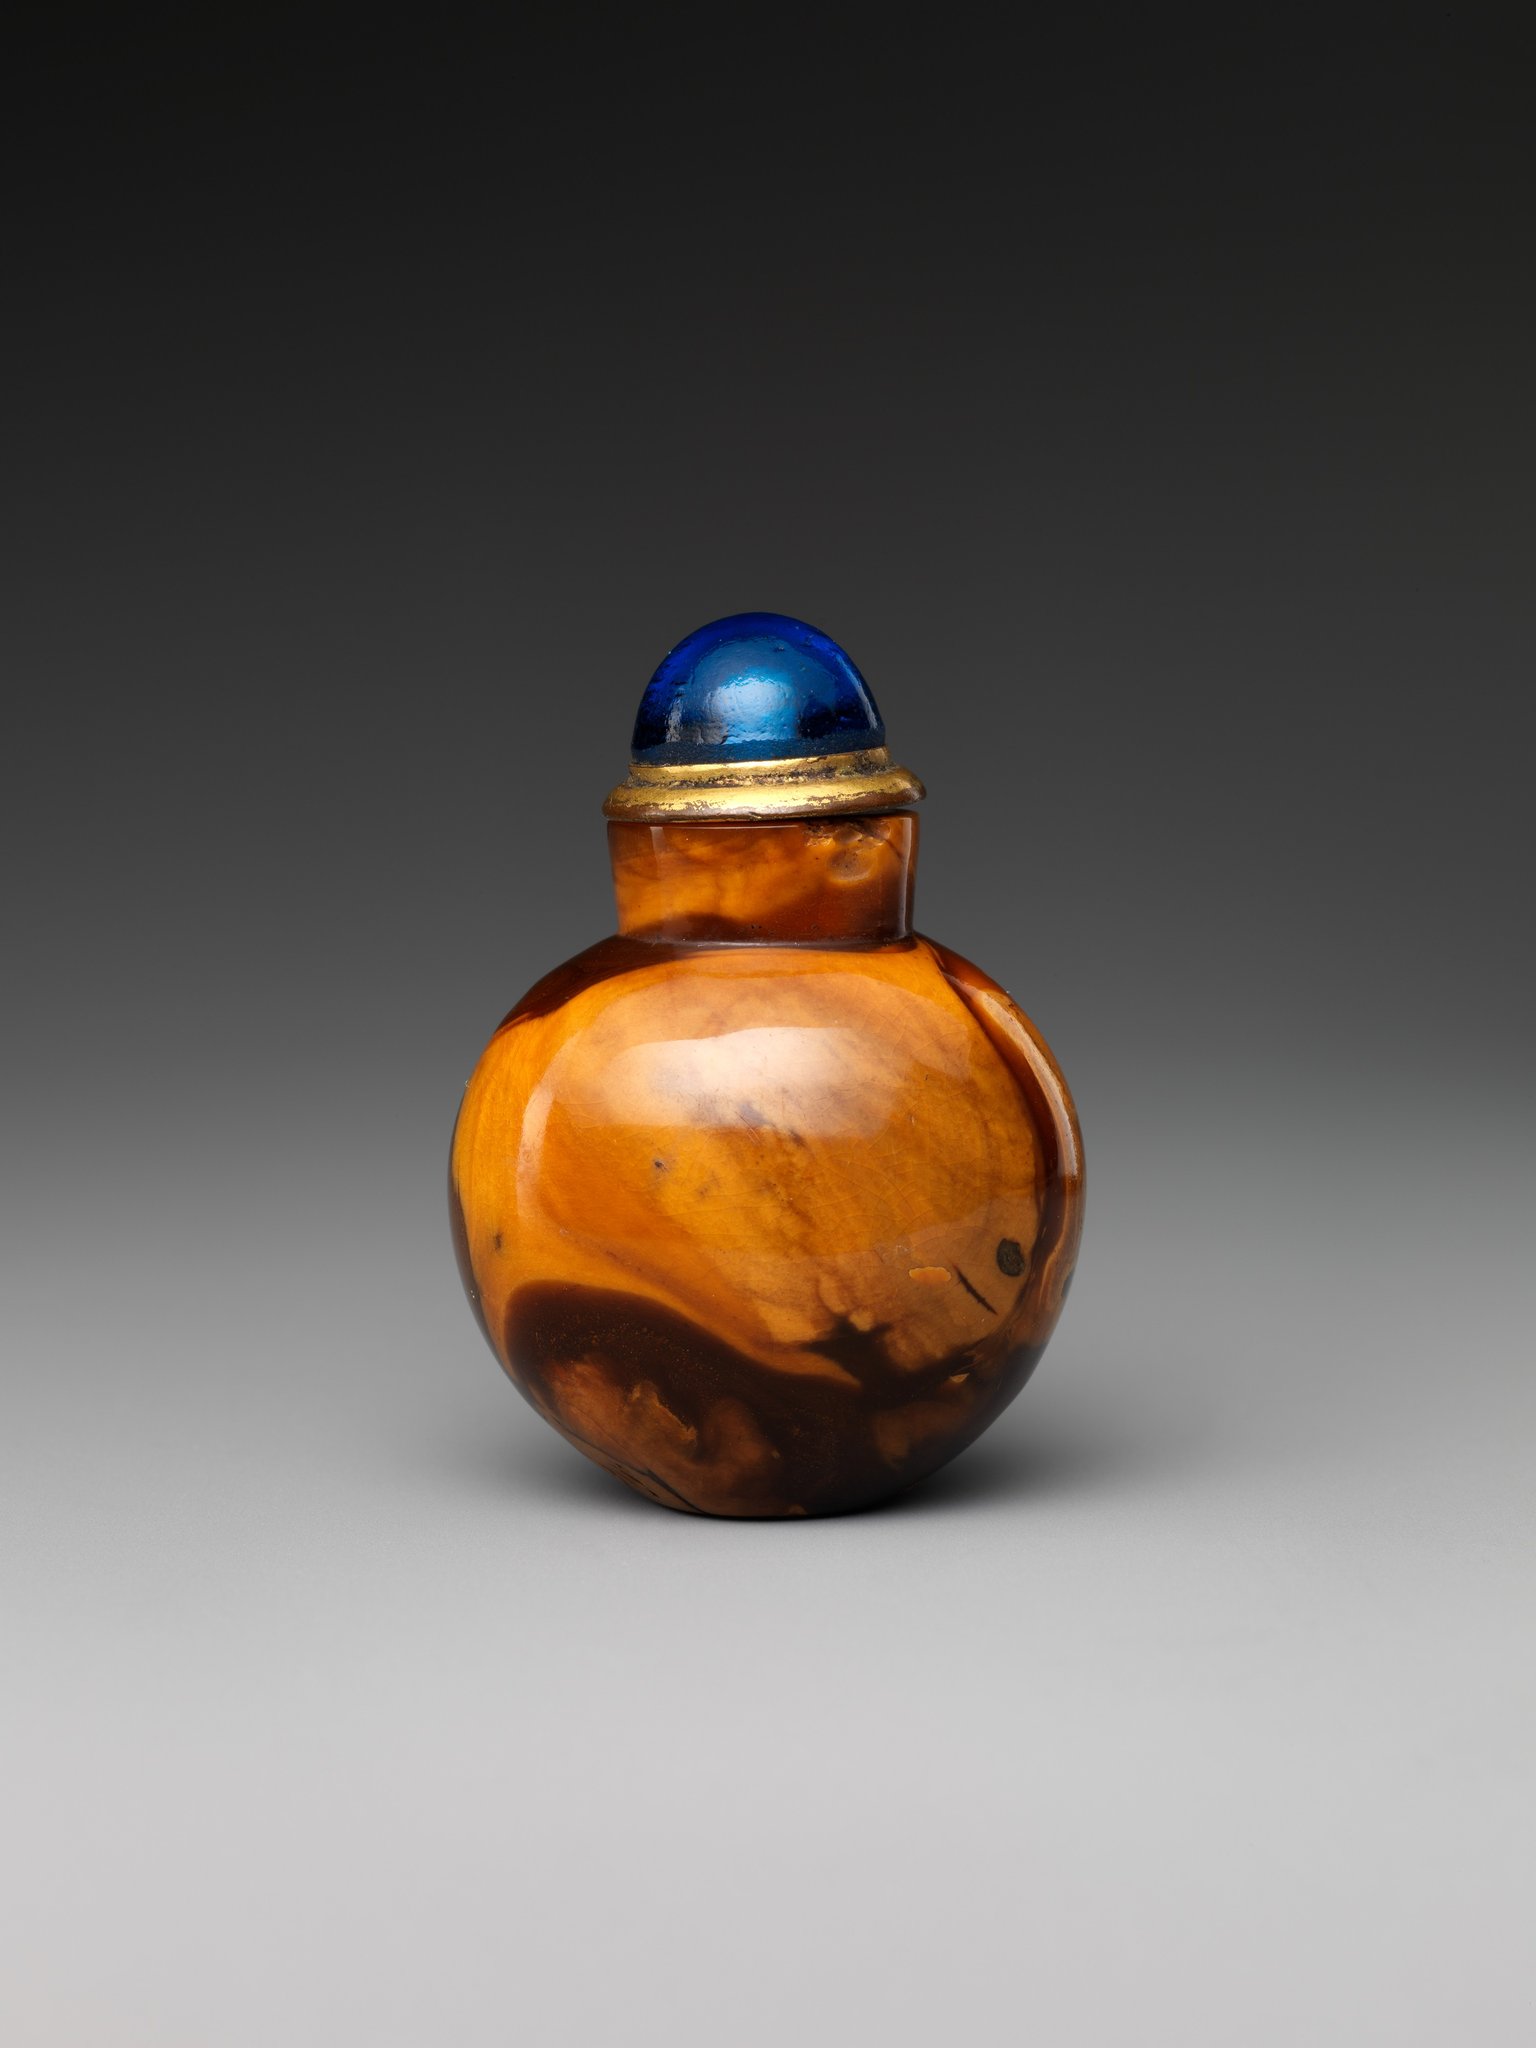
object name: snuff bottle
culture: chinese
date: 1801-1900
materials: amber, glass